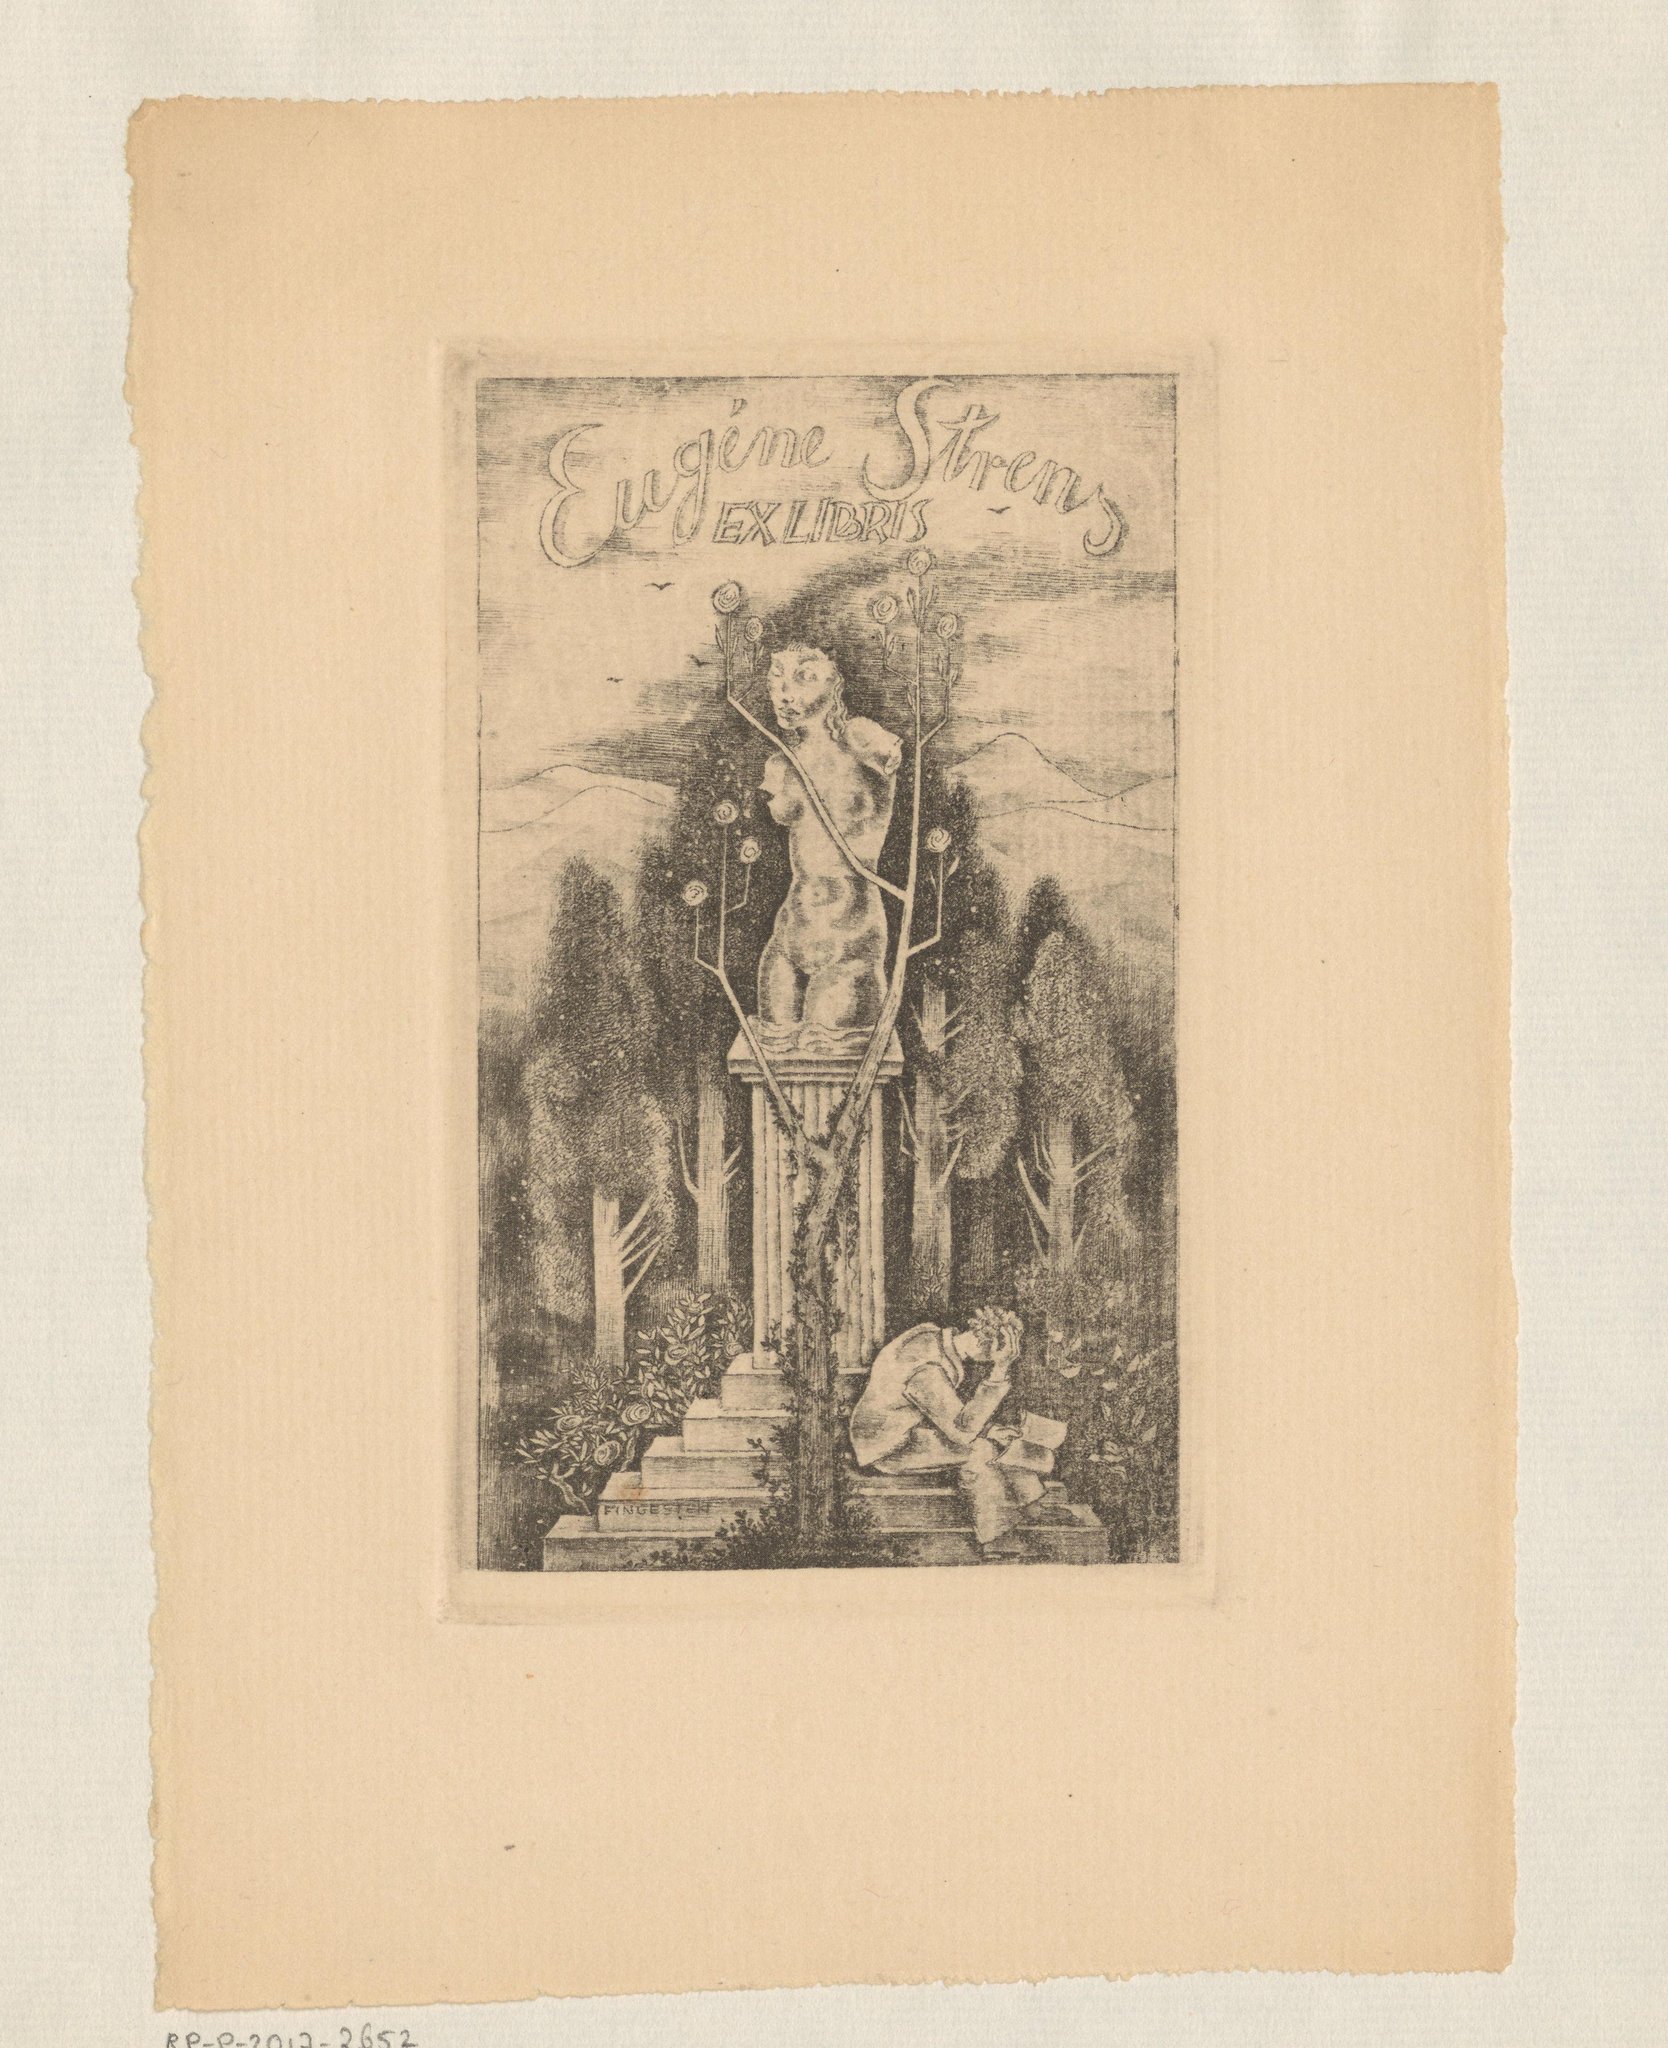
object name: photomechanical print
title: Ex libris van Eugène Strens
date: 1937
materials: paper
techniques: rotogravure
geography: italy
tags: engineer, eugène louis charles marie strens, reading, woman (showing herself) undressed, quasi-nude, shrubs: rose-bush, book, forest, wood, sculpture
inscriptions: inscription: ‘Michel Fingesten / 1937’